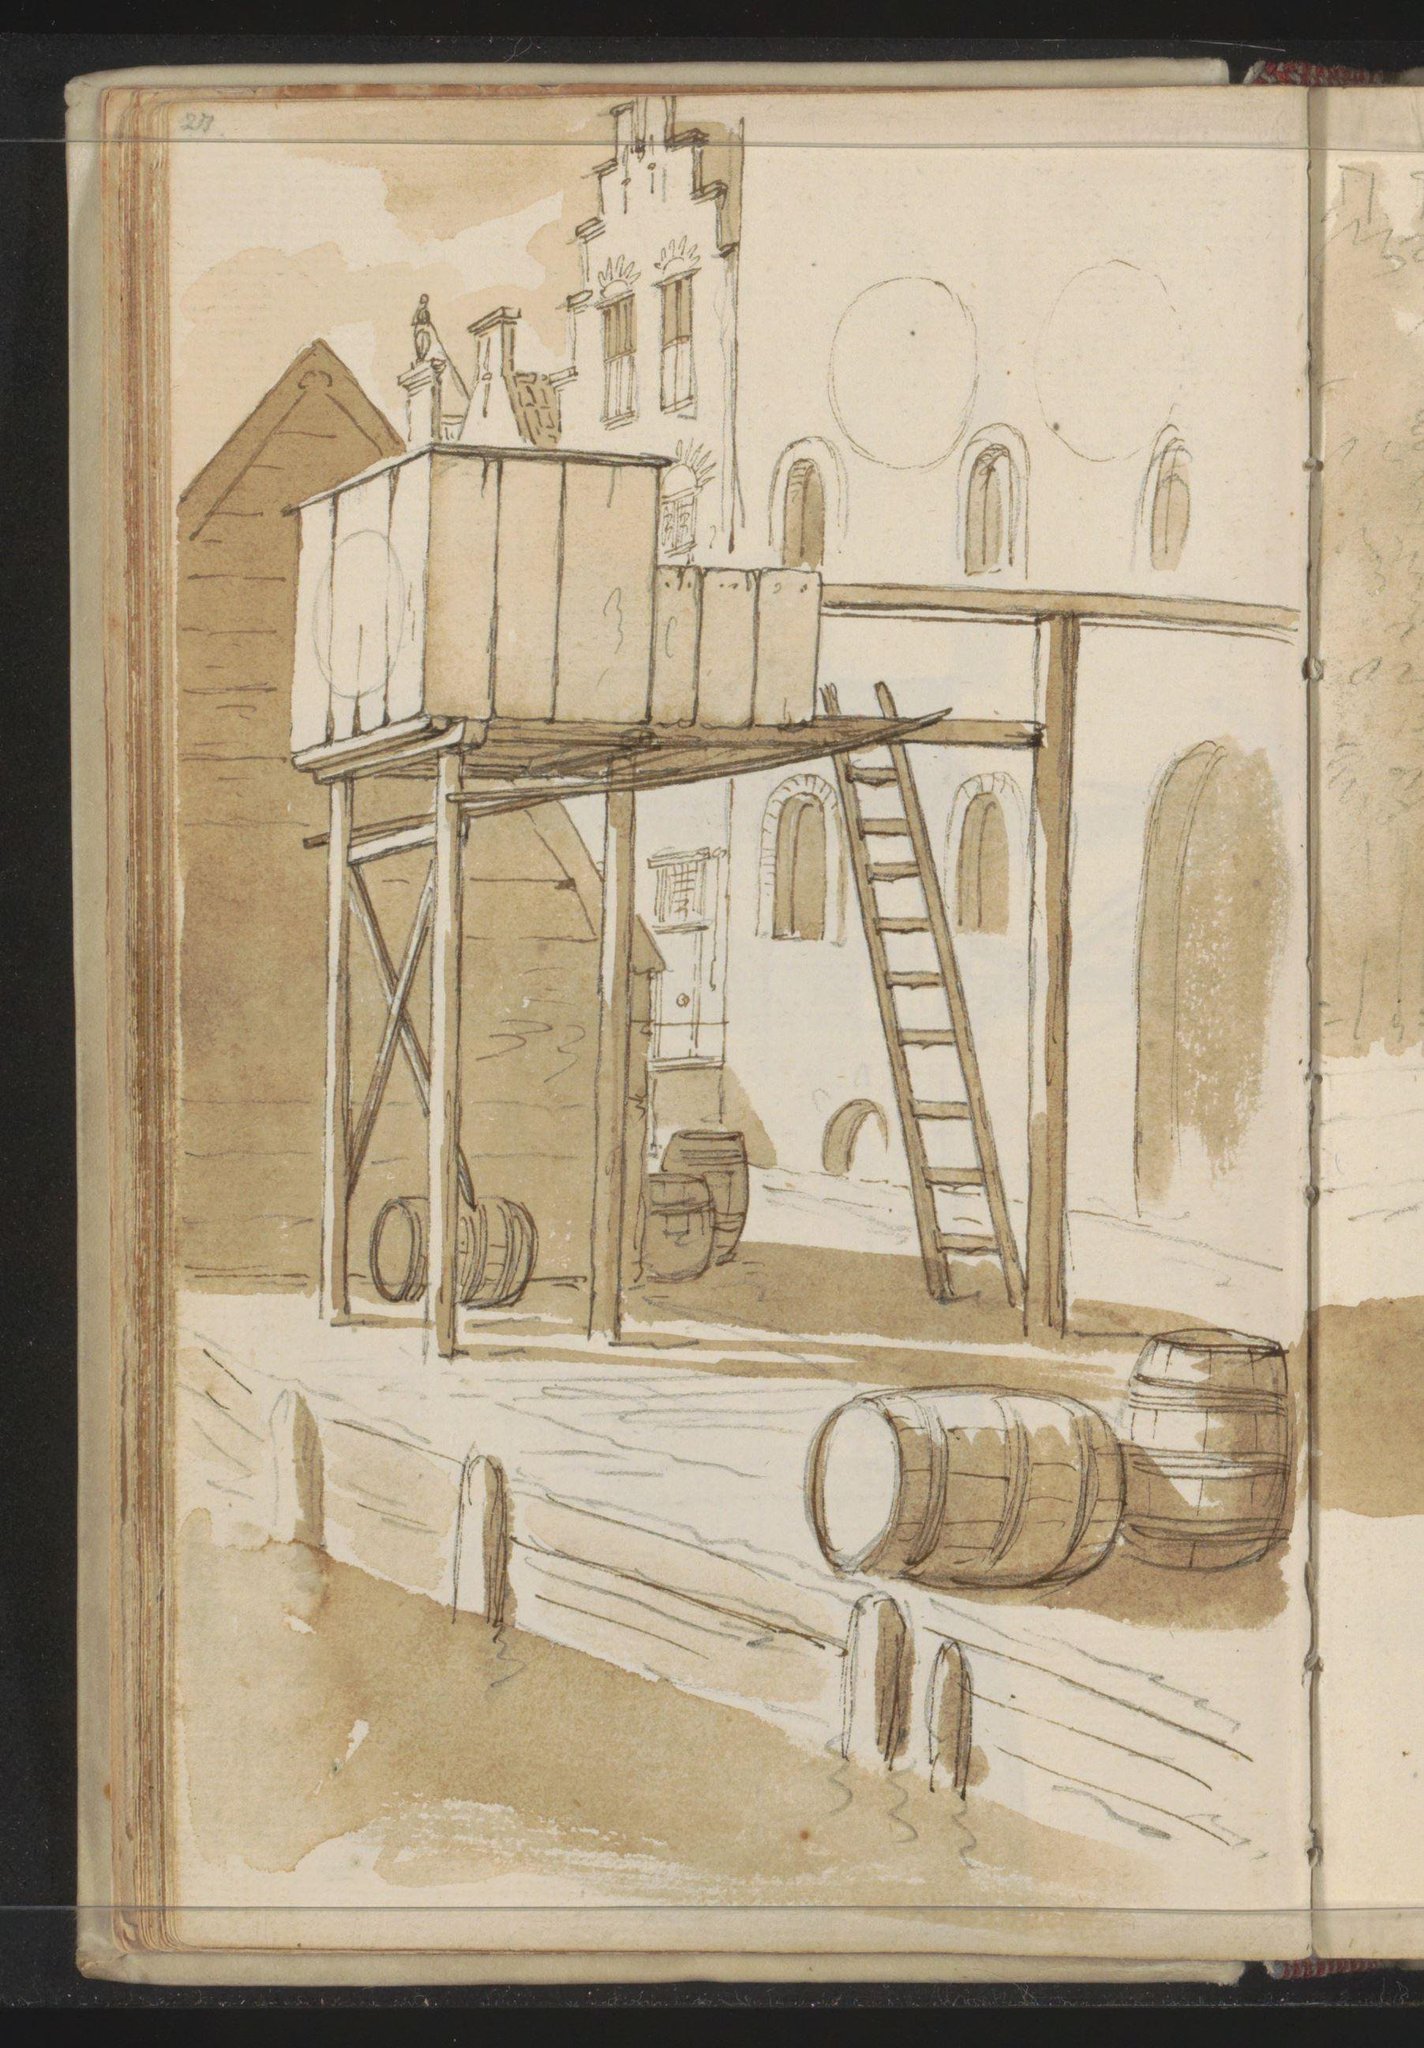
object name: sketchbook leaf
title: Houten tonnen op een kade bij een pakhuis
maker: johannes huibert prins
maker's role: draughtsman, painter, print maker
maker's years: 1757-1806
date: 1783-1797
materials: ink, paper, pencil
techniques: brush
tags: wooden container: barrel, cask, bucket, pier, quay, wharf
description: Pagina 27 uit een schetsboek met 175 pagina's.